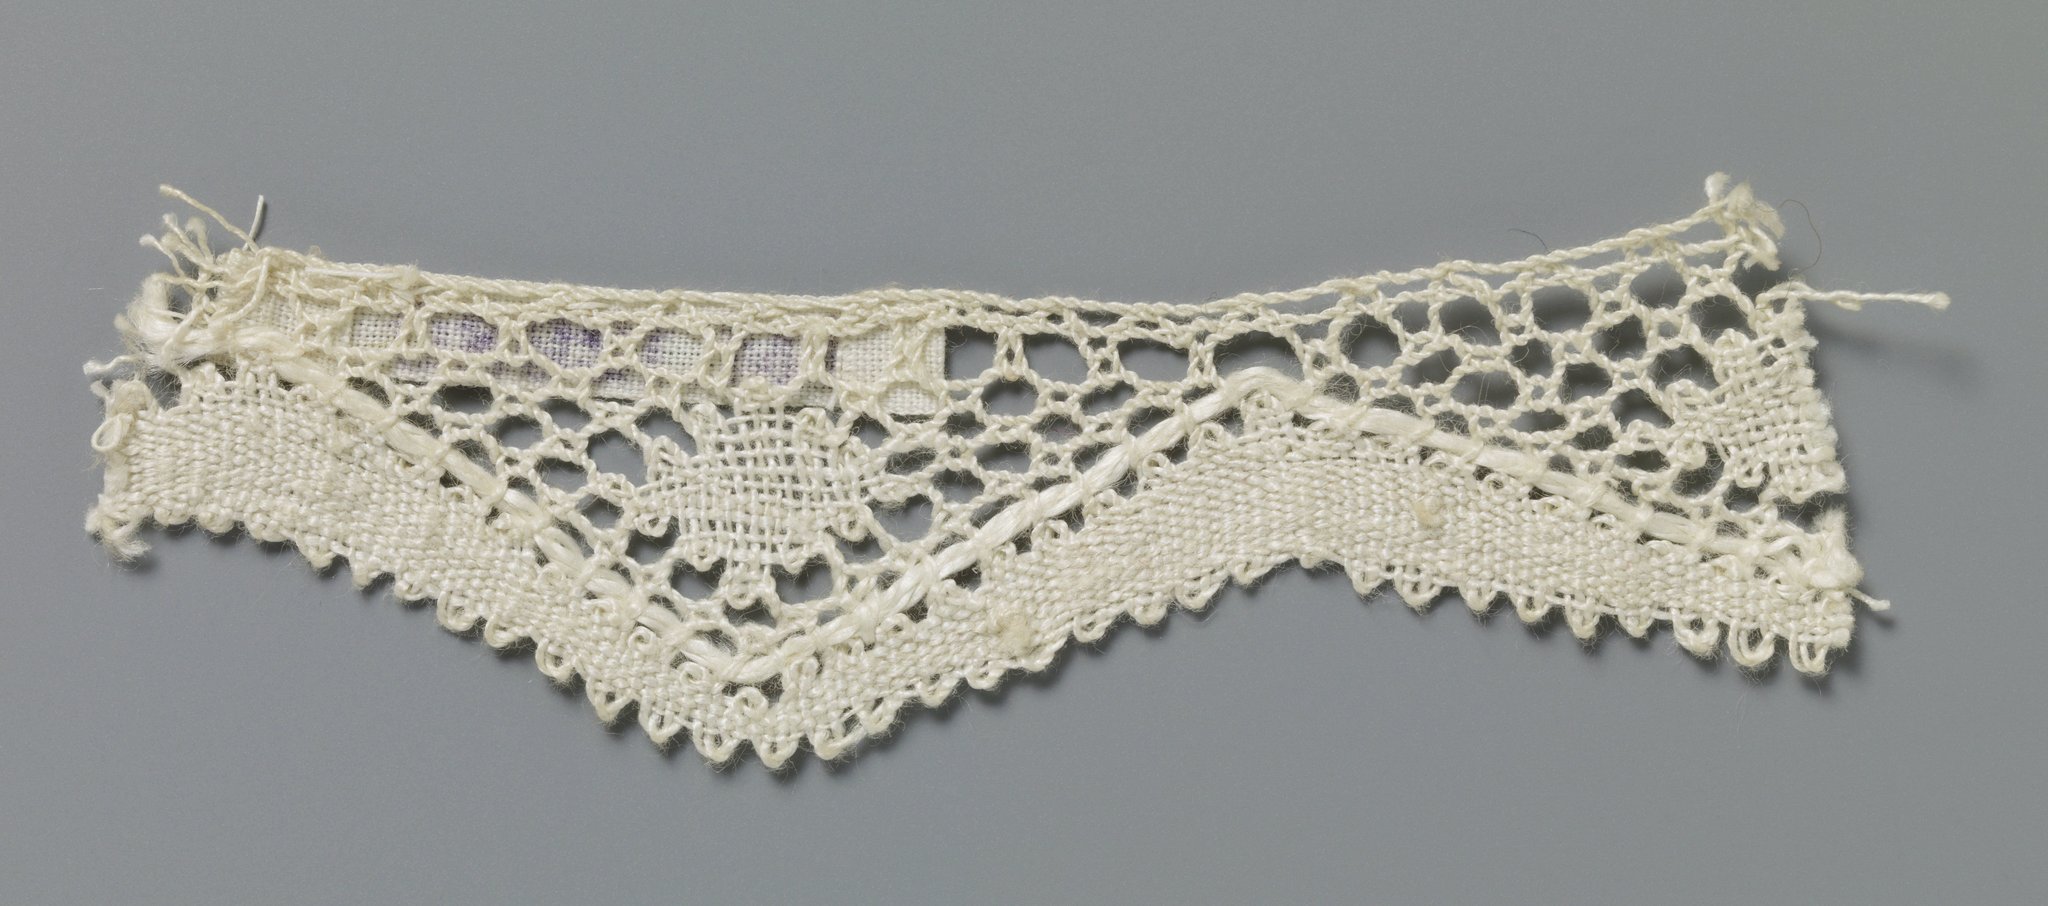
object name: strip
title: Strook kloskant met ruit in zigzag-schulpen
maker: Anonymous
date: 1800-1899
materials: cotton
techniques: lace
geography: buckingham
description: Strook naturelkleurig kloskant, stropkant. Het zich herhalende patroon bestaat uit een losse ruit in zigzag-schulpen. De ruit is gemaakt in linnenslag, in een maasgrond, een gesloten speldslag-grond. Langs de zigzaggende onderzijde loopt een band in linnenslag, met een dikke contourdraad aan de bovenkant en voorzien van picots aan de onderkant. De bovenkant van de strook is recht afgewerkt.